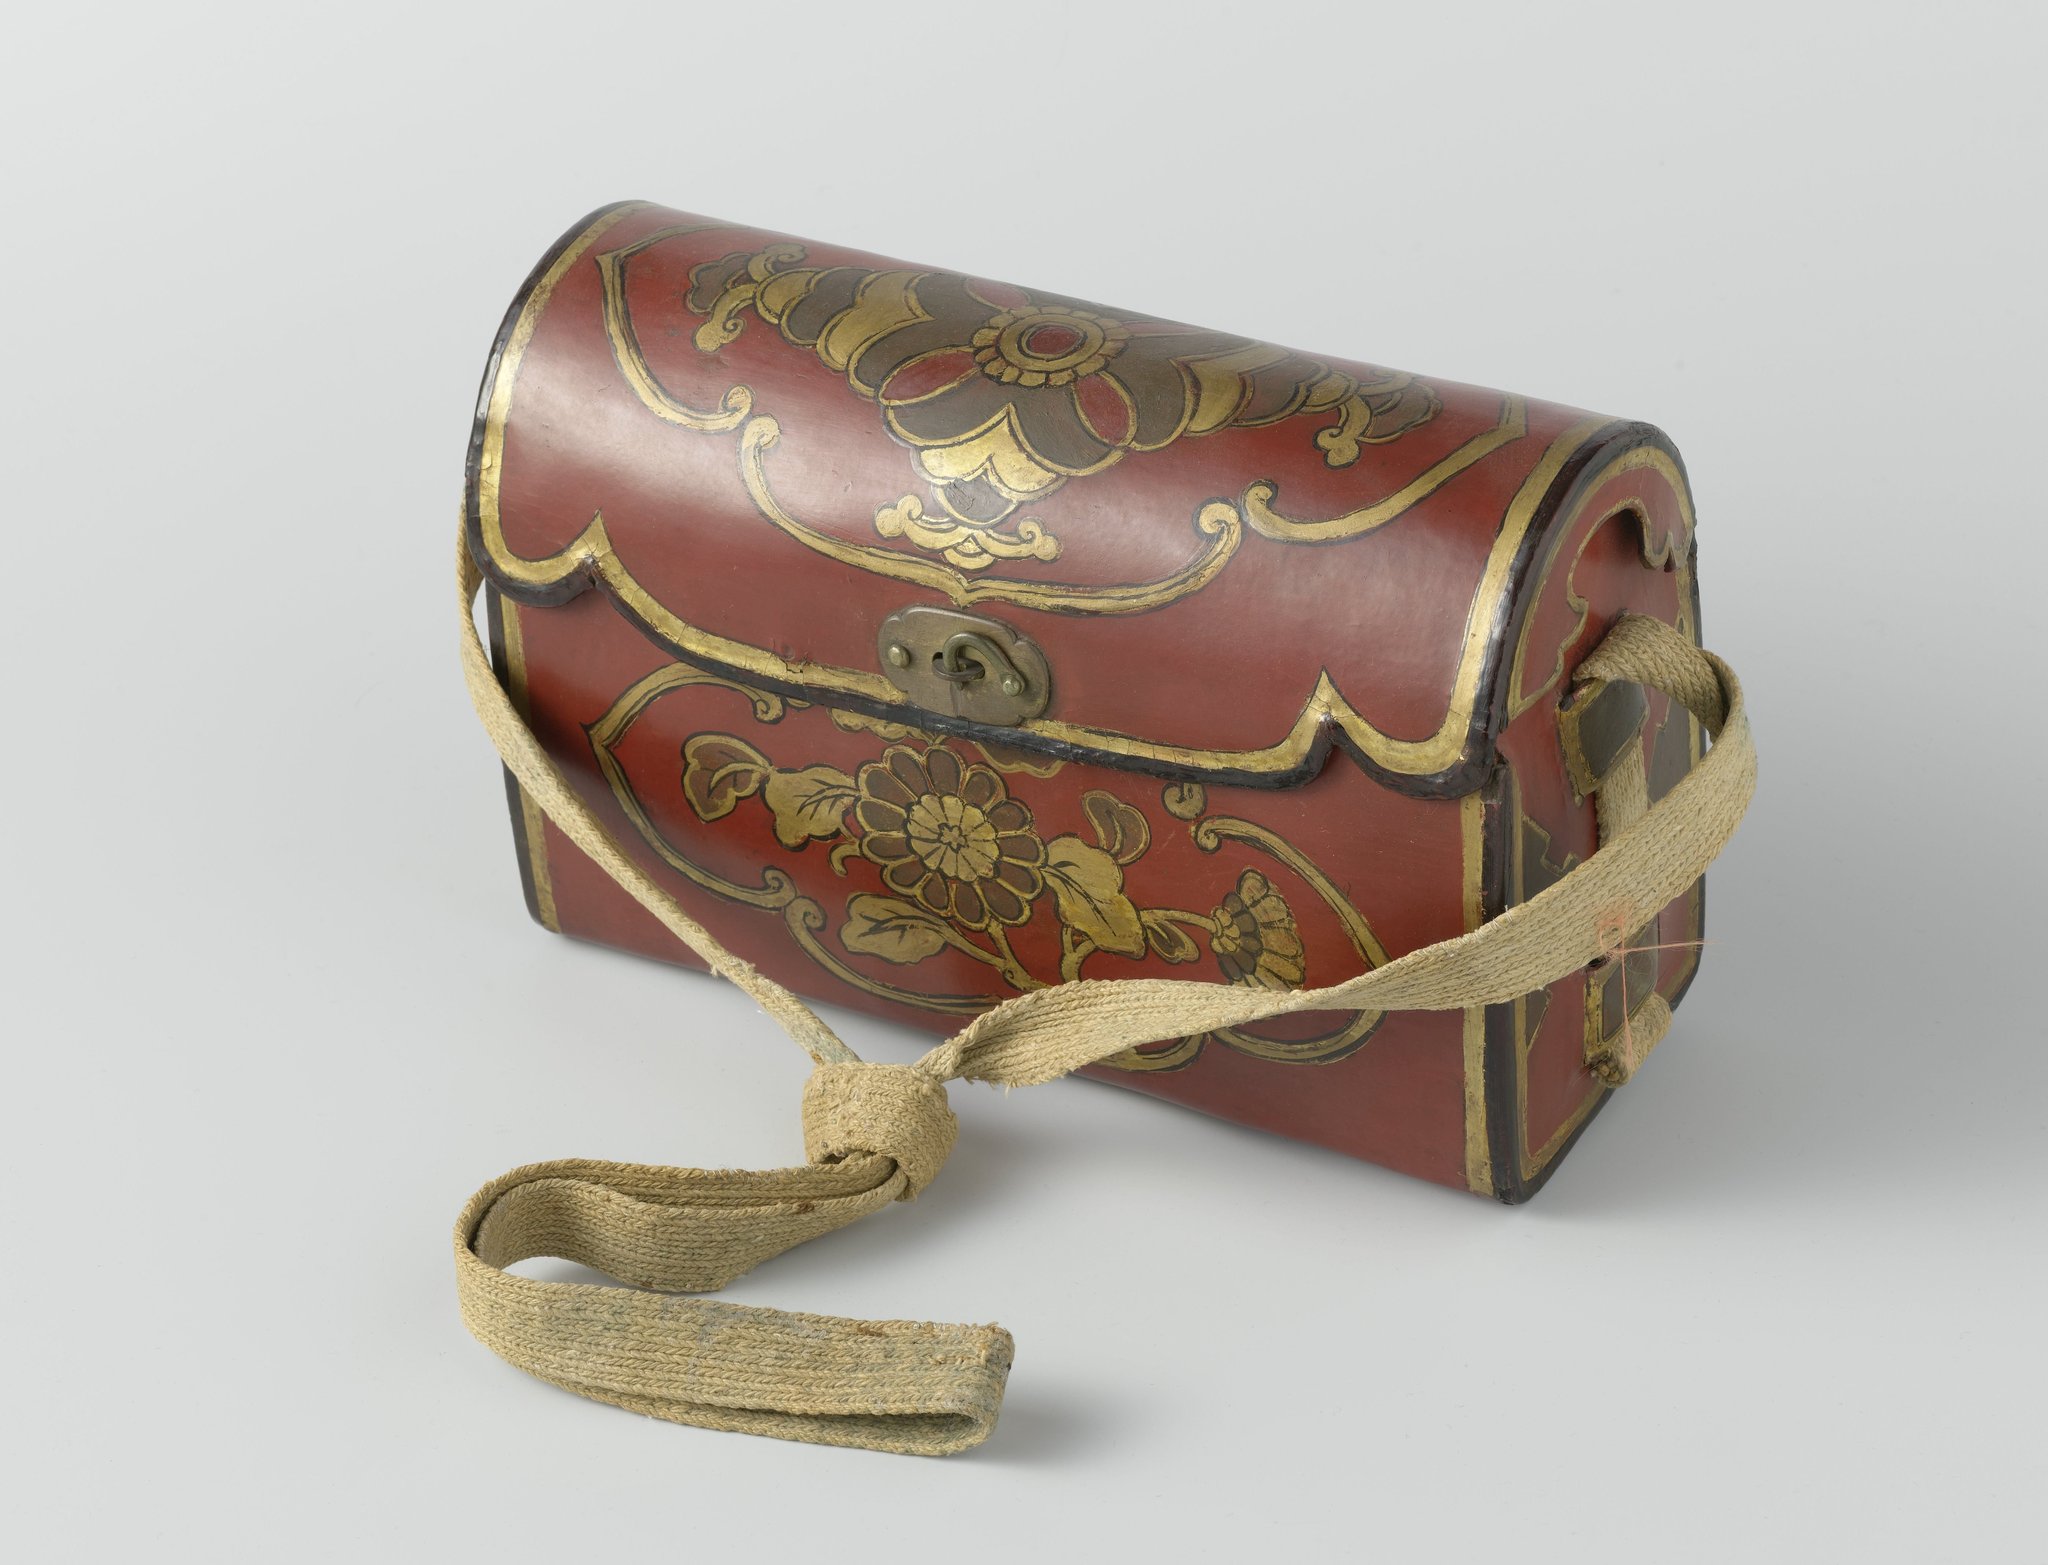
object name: cartridge pouch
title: Cartridge Bag Belonging to Cornelis Tromp’s Armoury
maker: Anonymous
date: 1650-1679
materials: brass, cotton, leather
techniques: gilding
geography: southeast asia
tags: rotterdam, cornelis tromp, flowers ~ ornament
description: Small bags are increasingly carried by men these days, but they are not a new phenomenon. This bag, in the form of a box with shoulder strap, was designed to hold cartridges for a pistol. Although this bag is a functional object, rather than a fashion accessory, its elaborate decoration with red lacquer and gilding indicates that it was used ceremonially.